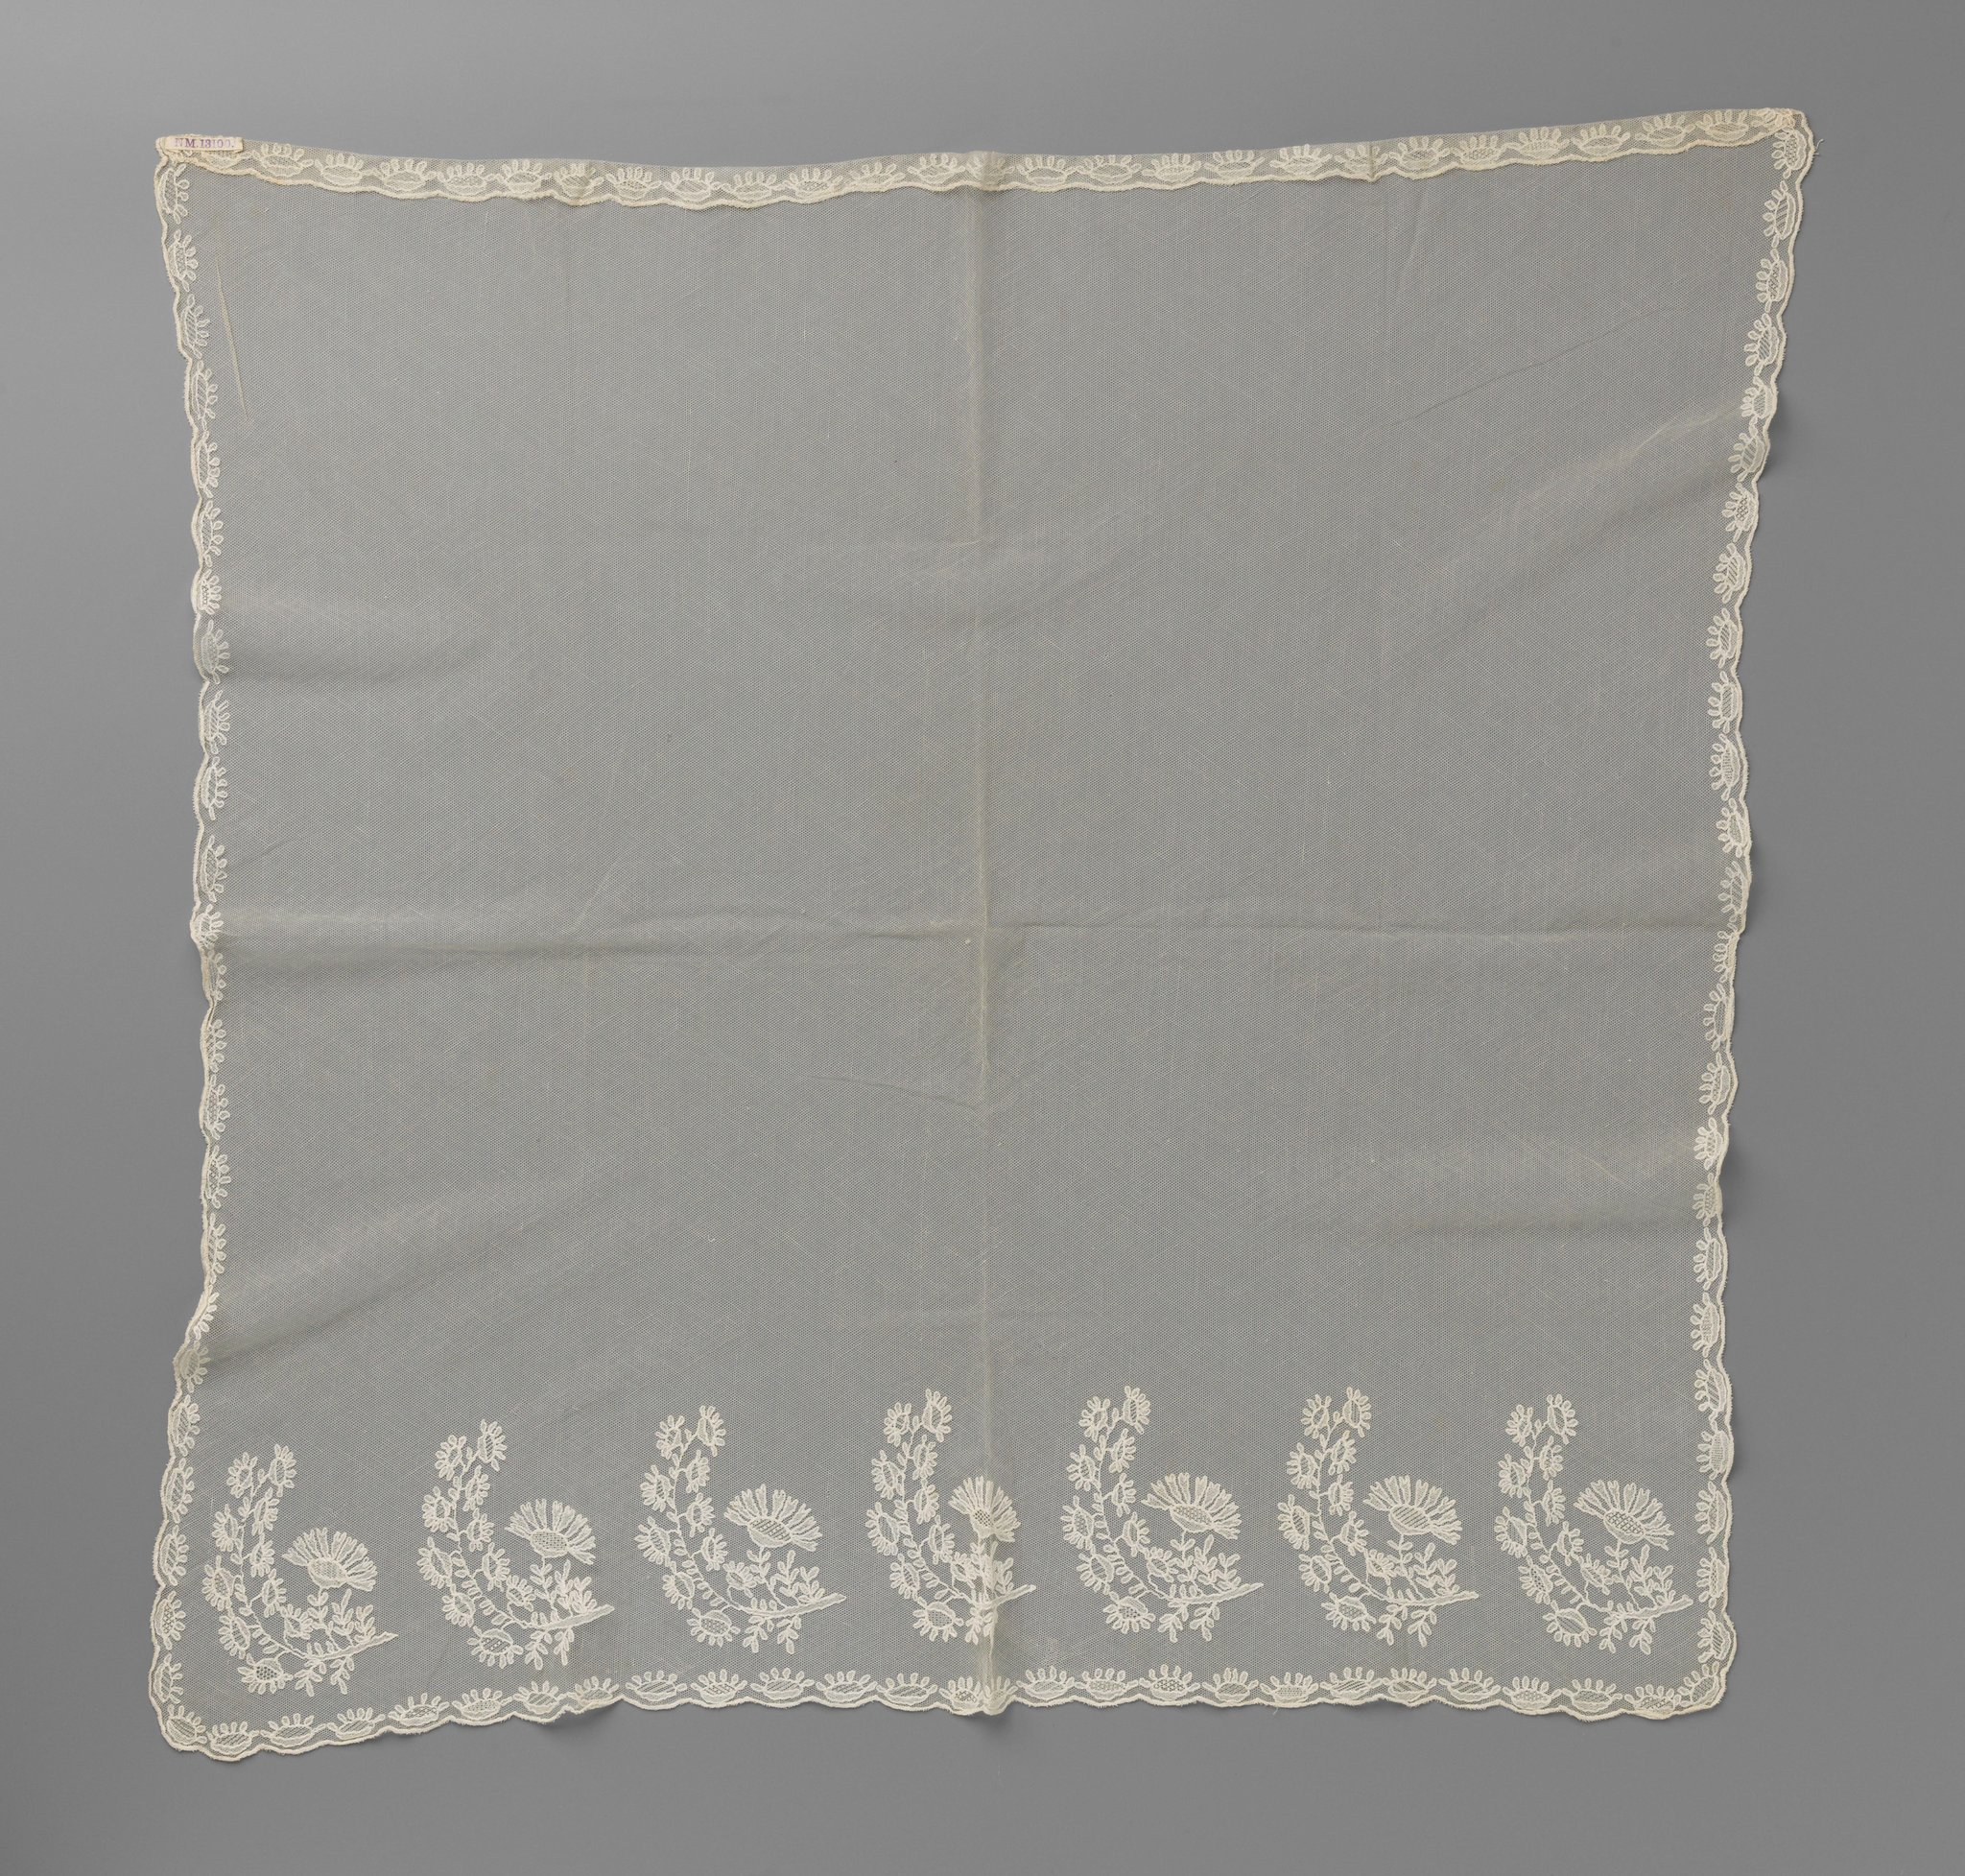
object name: womenswear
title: Hoedensluier van machinale tule met ovale bloemen aan c-vormige takken en langs de randen in tuledoorstopwerk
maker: Anonymous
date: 1830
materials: linen, fiber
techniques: lace embroidery, tulle darning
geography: netherlands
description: Hoedensluier van naturelkleurige machinale tule met langs de randen naturelkleurig kantborduurwerk: tuledoorstopwerk. Vierkant model met flauw geschulpte randen. Langs de onderkant van de sluier staat een rij met zeven dezelfde dunne c-vormige takken, die aan beide zijden bezet zijn met ovale bloemen aan een kort steeltje en met een rand bloemblaadjes langs de bovenste helft. Een grotere bloem ontspringt onderaan de tak en staat centraal in de C. Langs alle zijden loopt een rand met steeds één ovale bloem in een schulp. In de bloemharten zijn siergronden toegepast. De bovenste rand is omgeslagen en vastgezet, deze zoom is even breed als het randpatroon met de ovale bloemen.